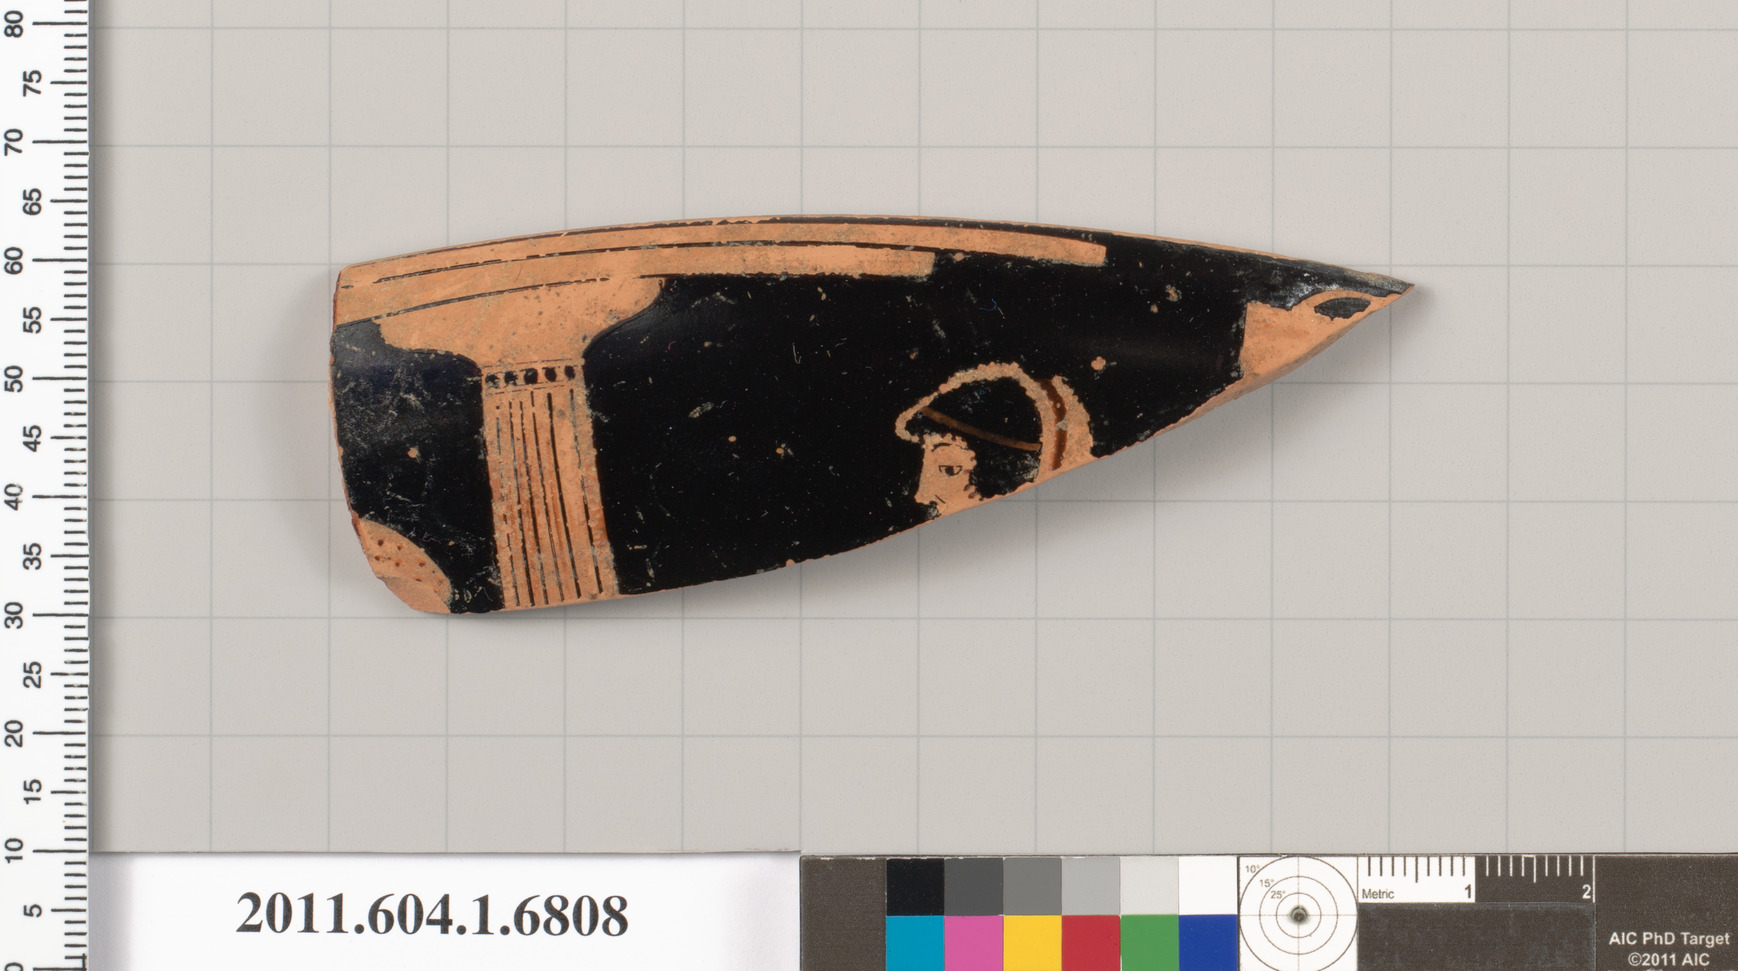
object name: kylix fragment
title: Terracotta rim fragment of a kylix (drinking cup)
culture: greek, attic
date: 490-470 BCE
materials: terracotta